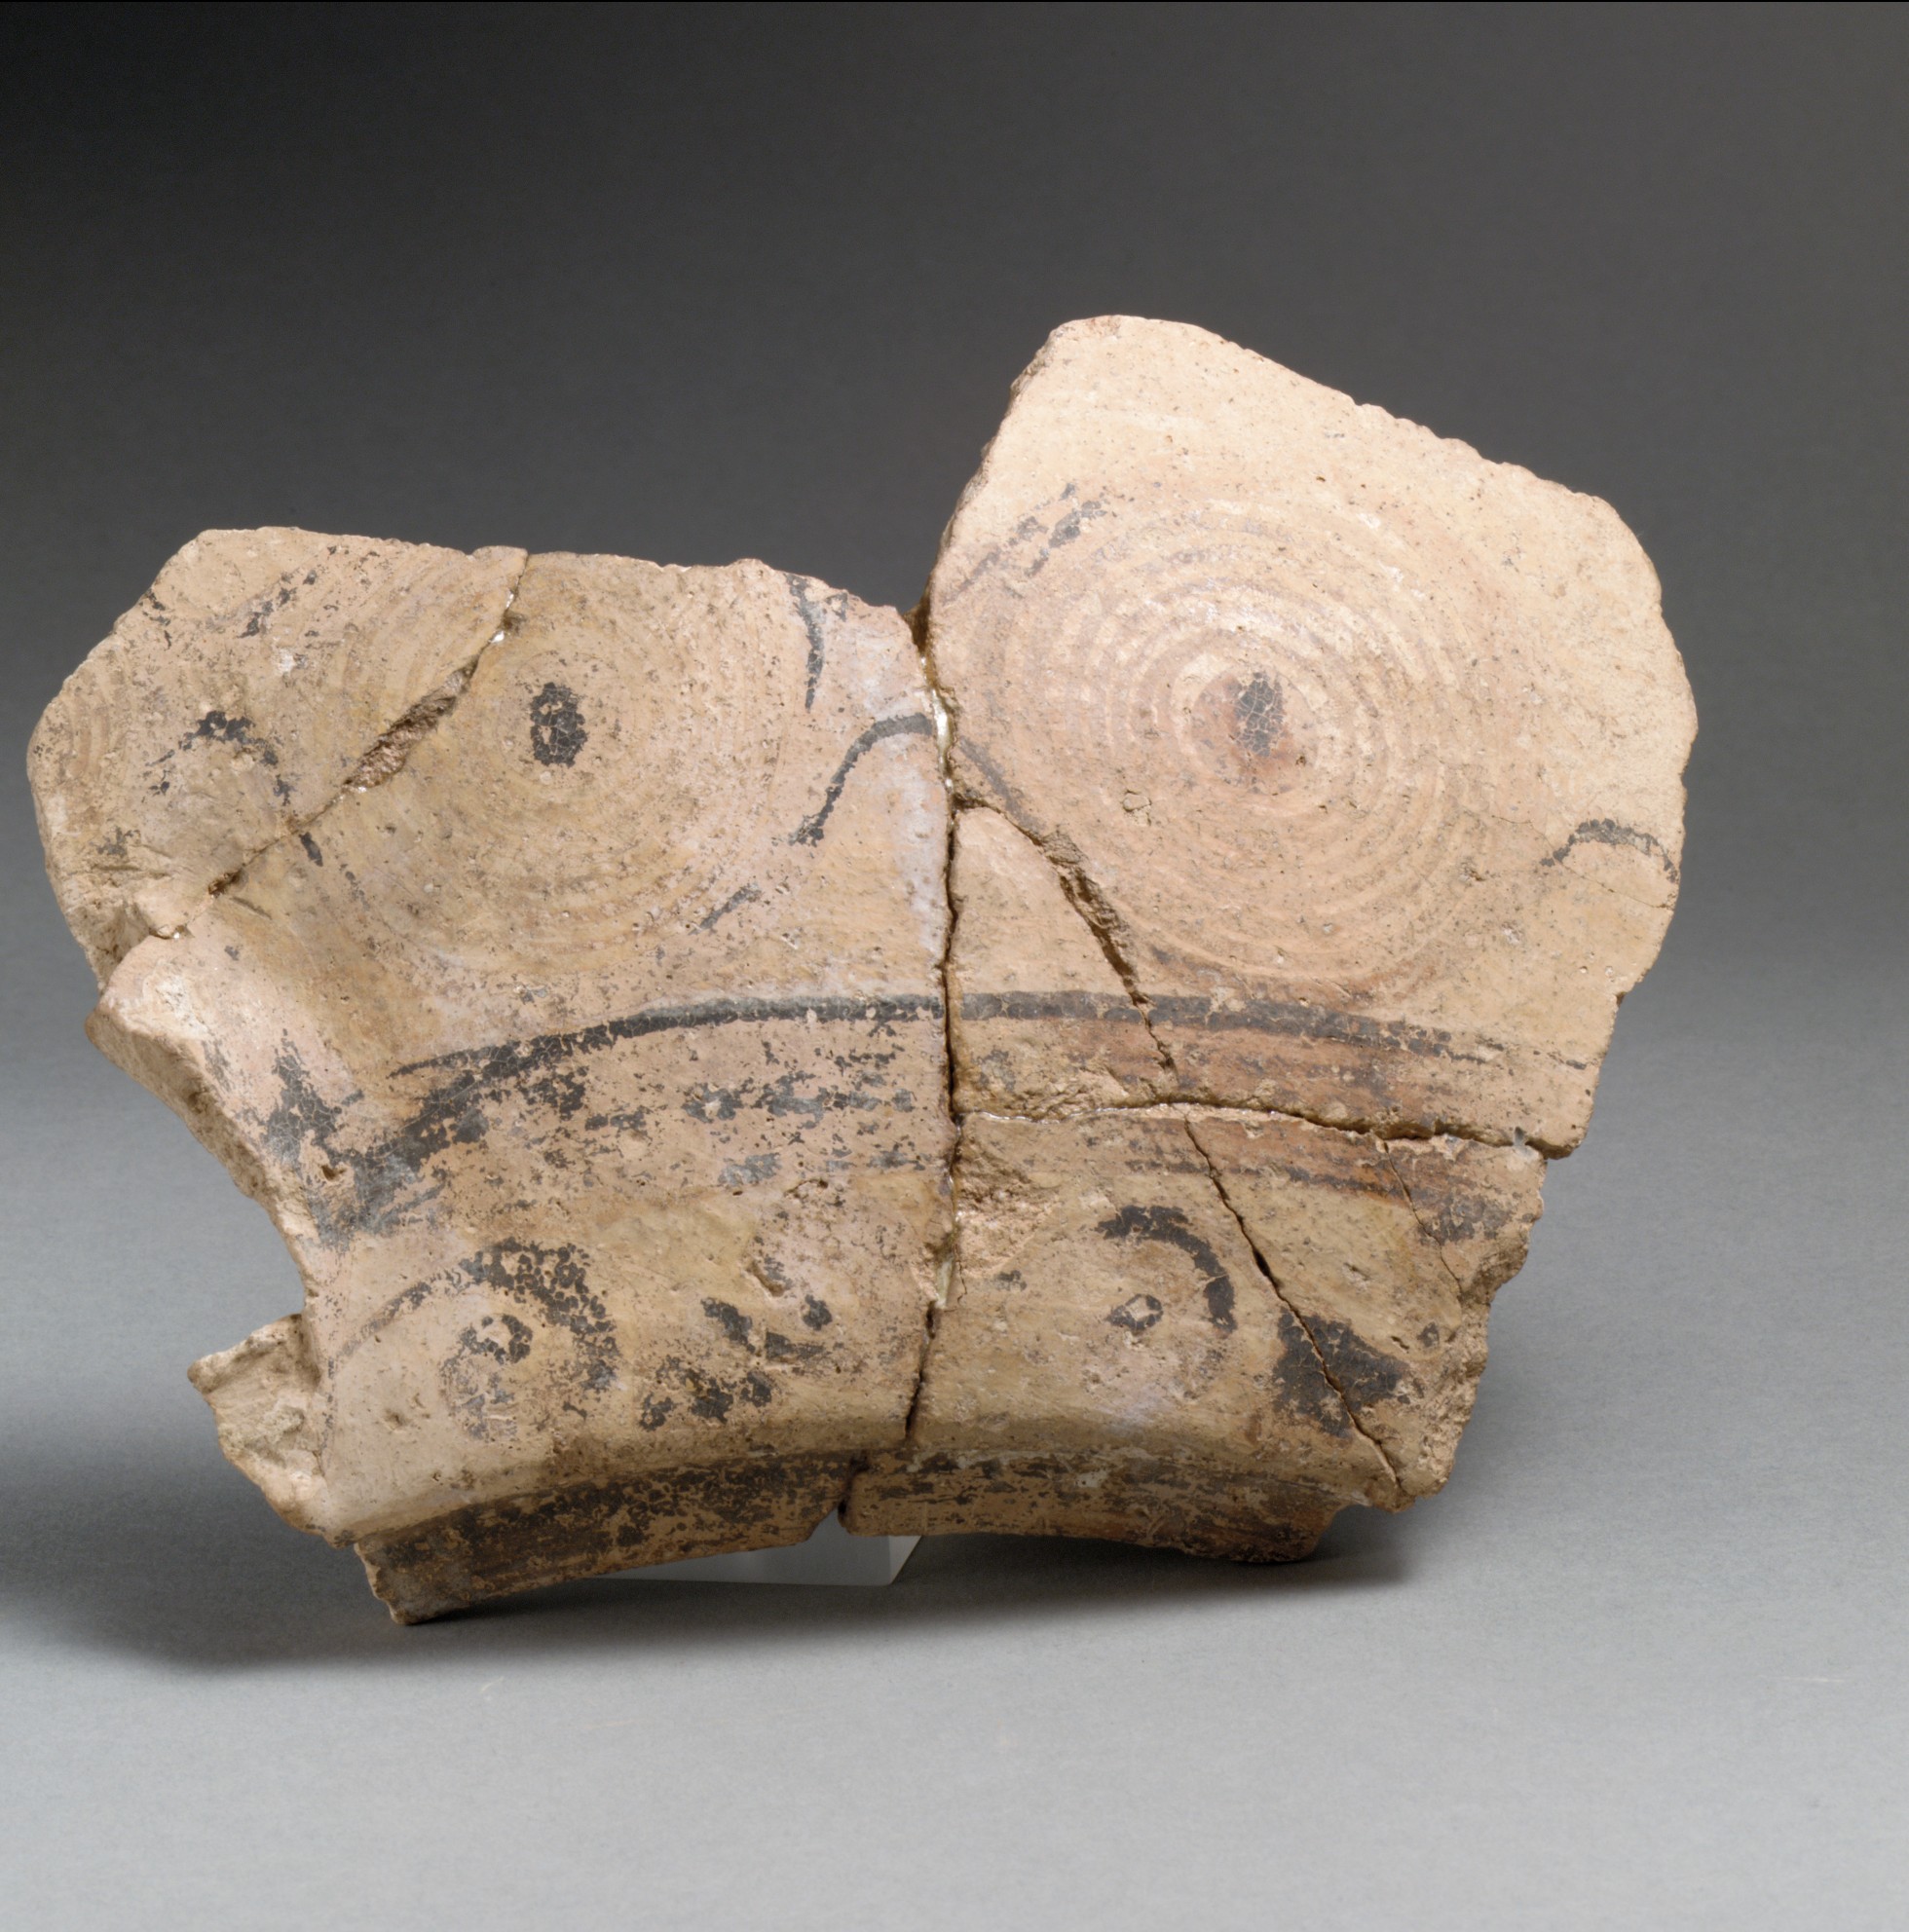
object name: vase fragment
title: Vase fragments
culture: minoan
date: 1600-1450 BCE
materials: terracotta